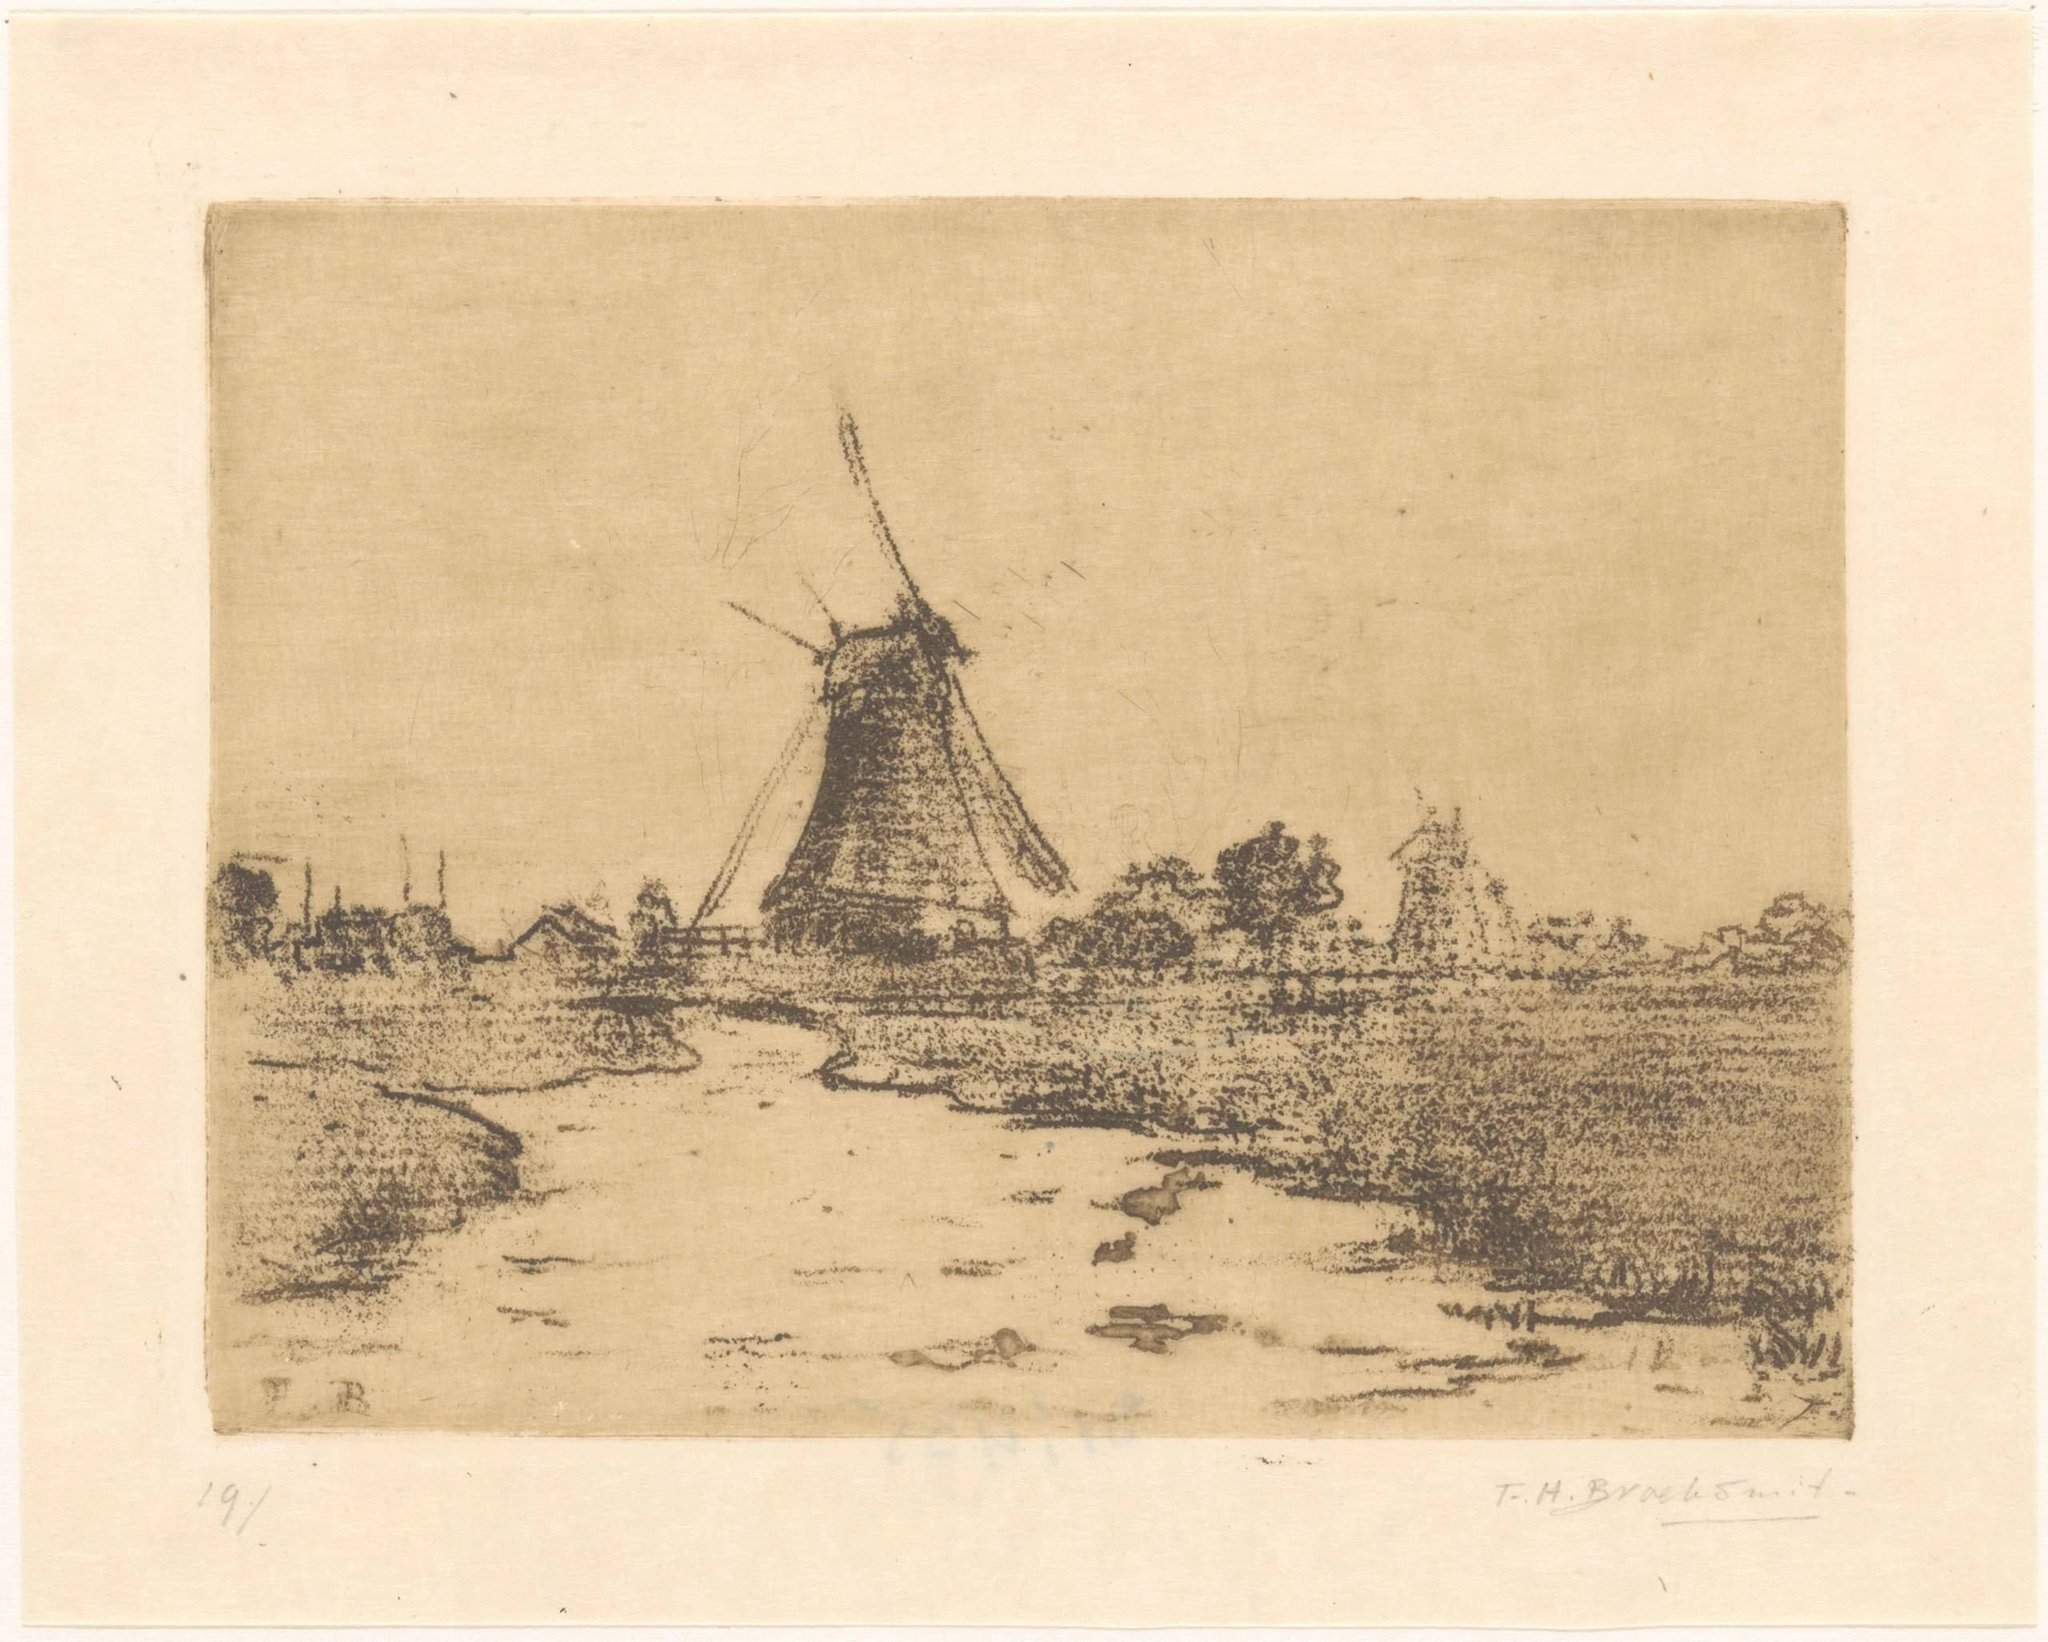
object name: print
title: Molen aan een sloot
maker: frederika henriëtte broeksmit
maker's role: draughtsman, print maker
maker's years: 1875-1945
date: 1885-1931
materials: paper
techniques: etching, intaglio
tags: swamps and polders, windmill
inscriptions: collector's mark: Lugt 2228